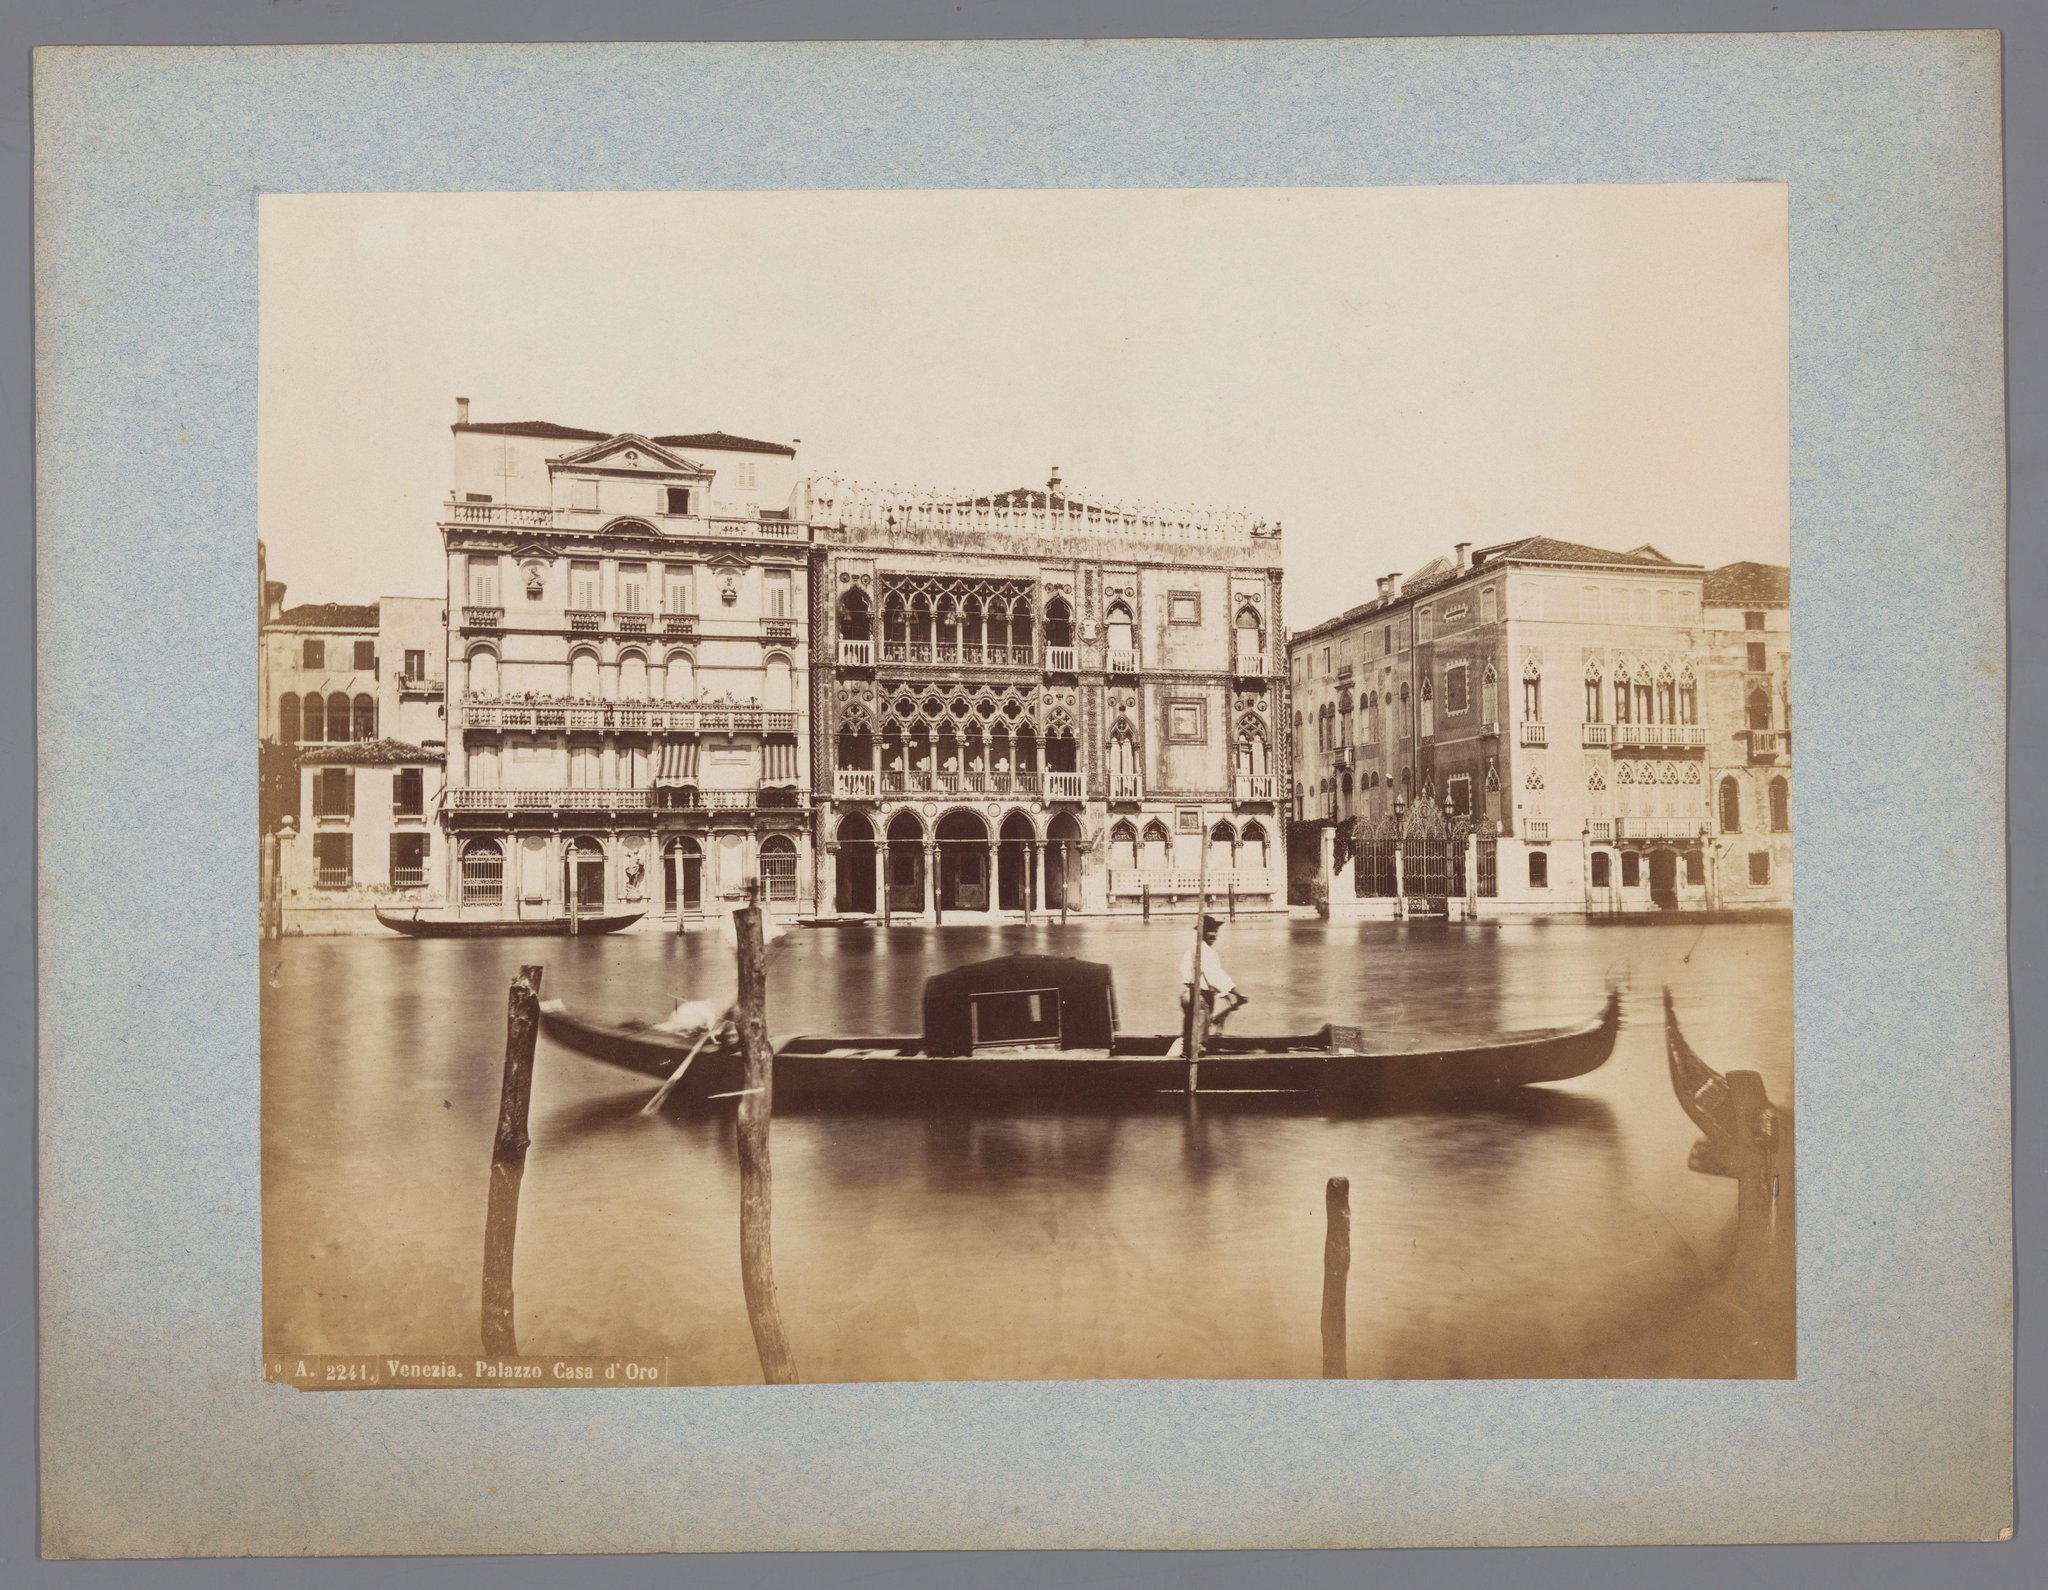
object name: photograph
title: Venezia. Palazzo Casa d'Oro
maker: Anonymous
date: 1851-1900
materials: cardboard, paper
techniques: albumen print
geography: venice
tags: canals, waters (in city), hôtel, i.e. small palace in city, gondola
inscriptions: collector's mark: ‘VOSMAER’, number: ‘No. A. 2241.’